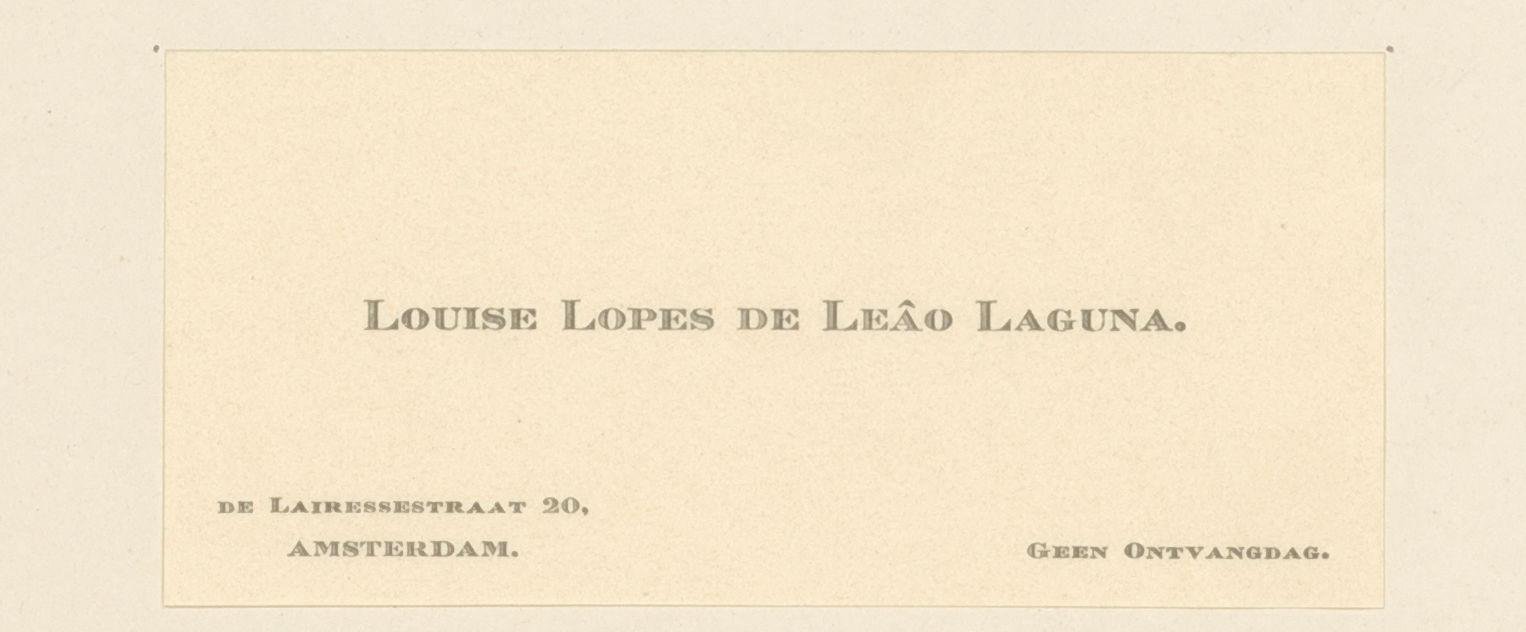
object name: text sheet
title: Kennisgeving van een verloving: visitekaartje van Louise Lopes de Leâo Laguna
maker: Anonymous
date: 1906-1917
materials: paper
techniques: letterpress printing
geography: netherlands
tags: amsterdam, den bosch, betrothal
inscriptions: collector's mark, collector's mark: Lugt 1641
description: Naamkaartje van Louise Lopes de Leâo Laguna. Kennisgeving van de verloving in juni 1917 van Louise Lopes de Leâo Laguna en mr. H.G.V. Hijmans. Onderdeel van een groep van twaalf objecten rondom het huwelijk in de familie Lopes de Leâo Laguna. Onderwerpsrubrieken binnen de Atlas Zeden en Gewoonten: Des Menschen Begin, Midden en Einde. Bruiloft en huwelijk.